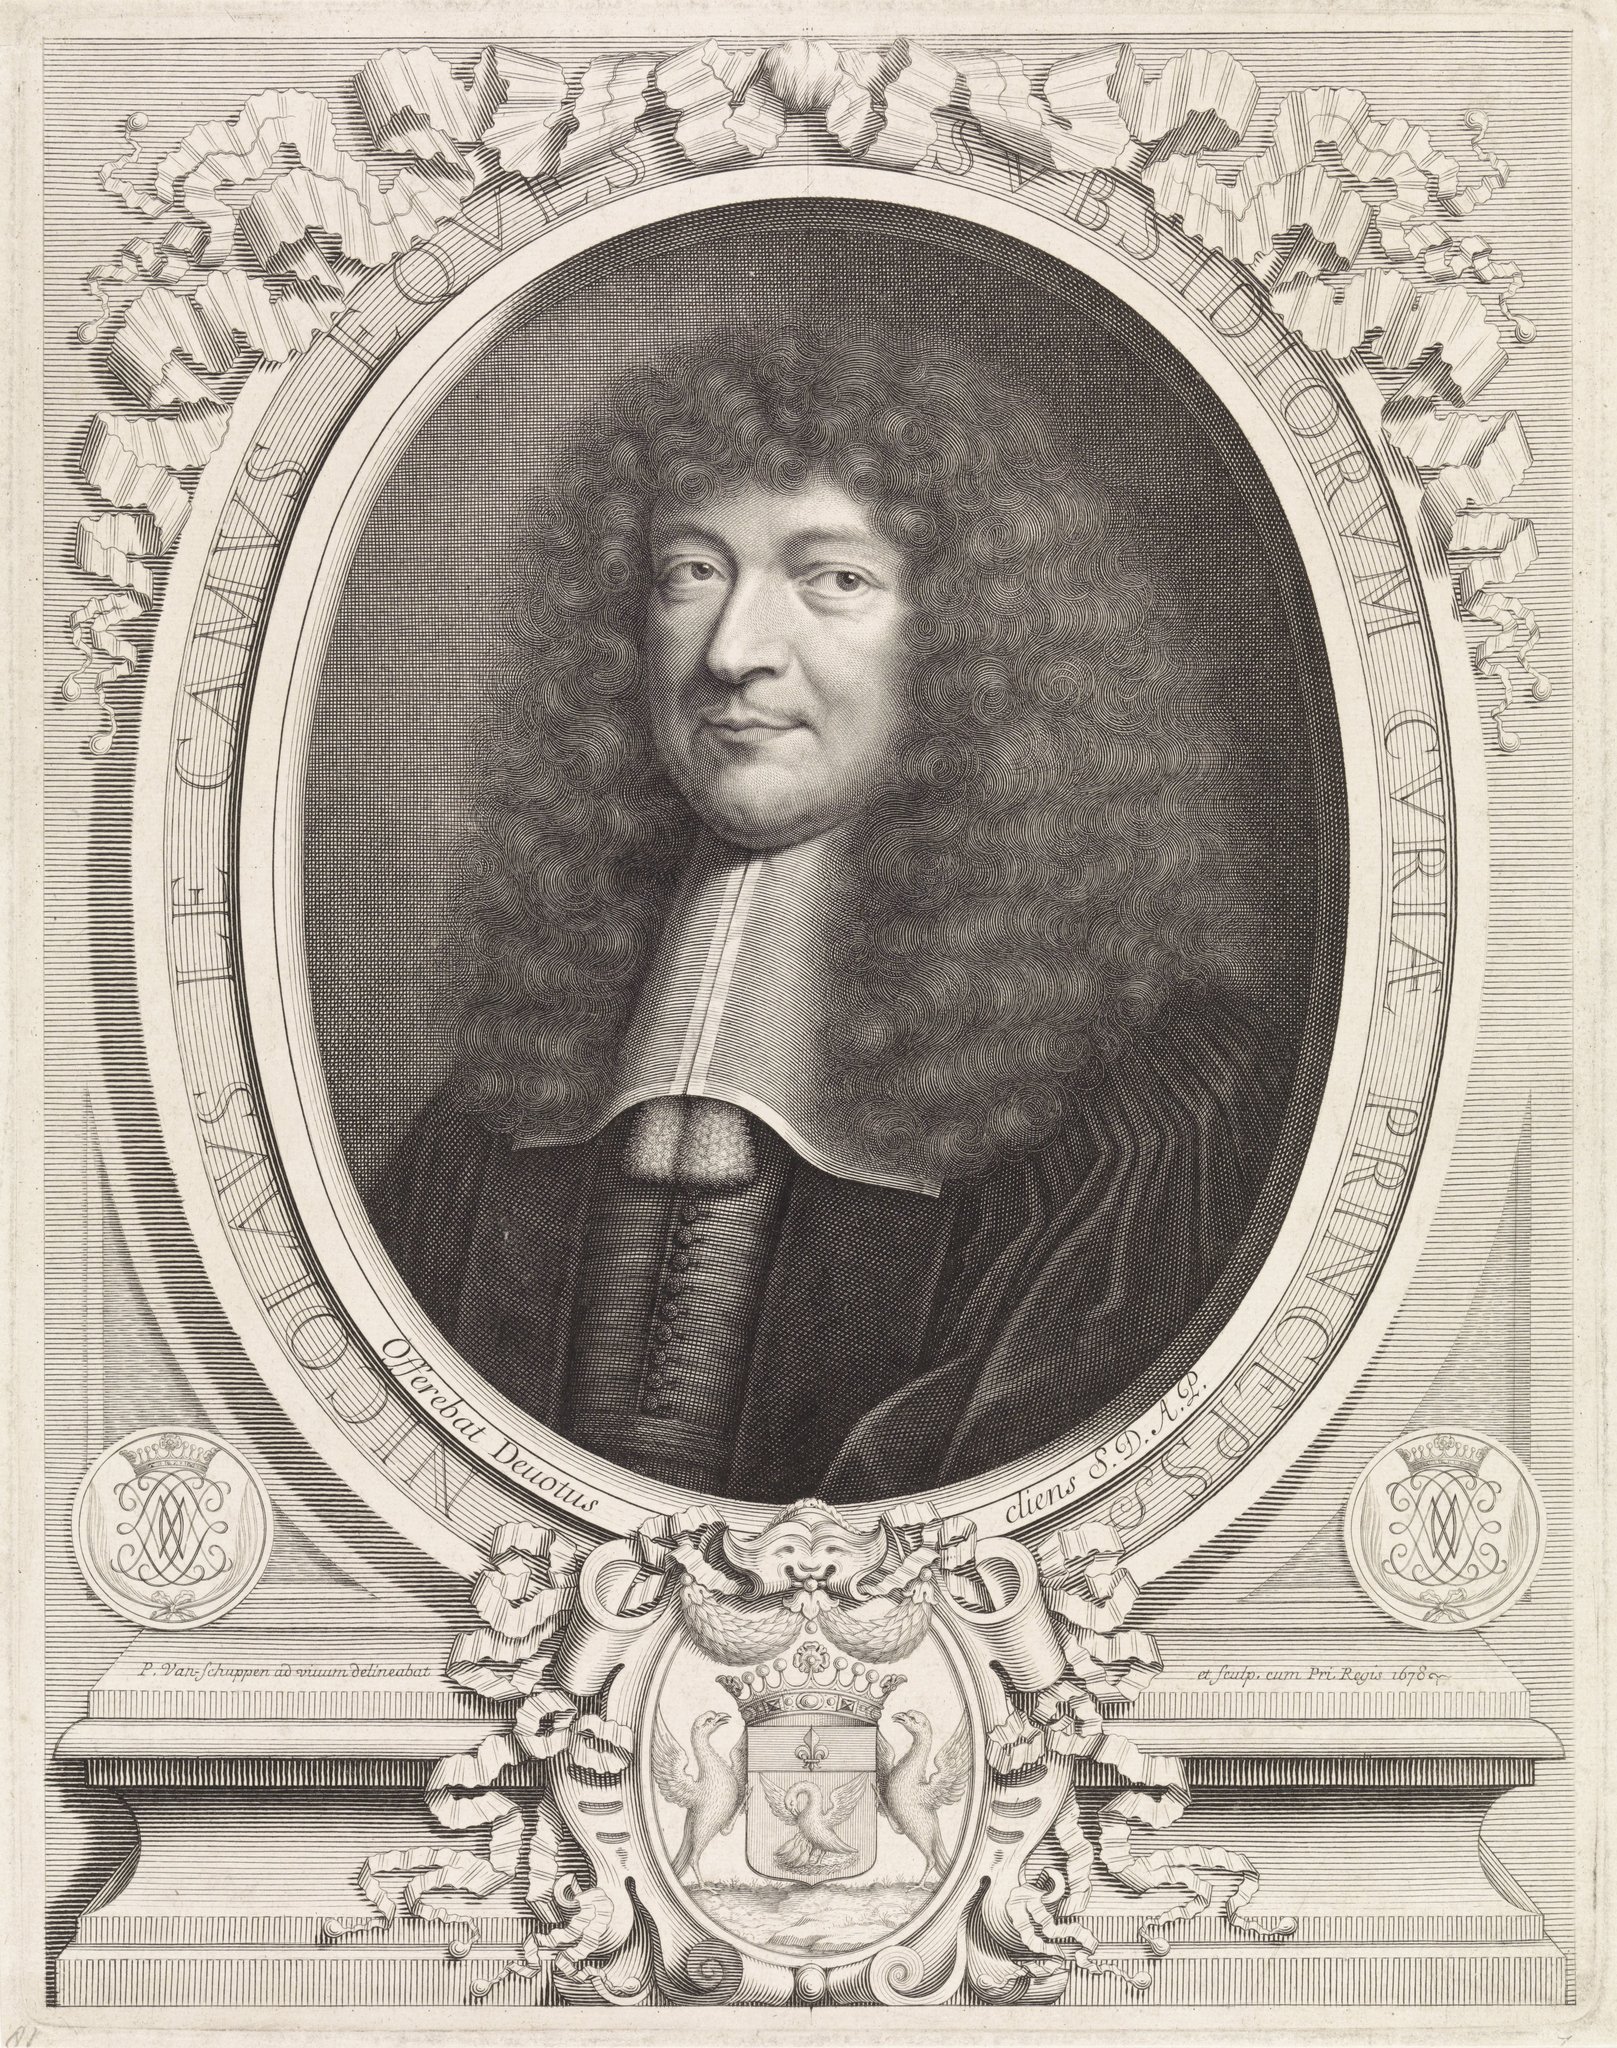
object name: print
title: Portret van de Franse staatsman Nicolas le Camus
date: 1601-1678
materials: paper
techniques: engraving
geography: paris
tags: nicolas le camus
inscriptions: collector's mark: Lugt 240